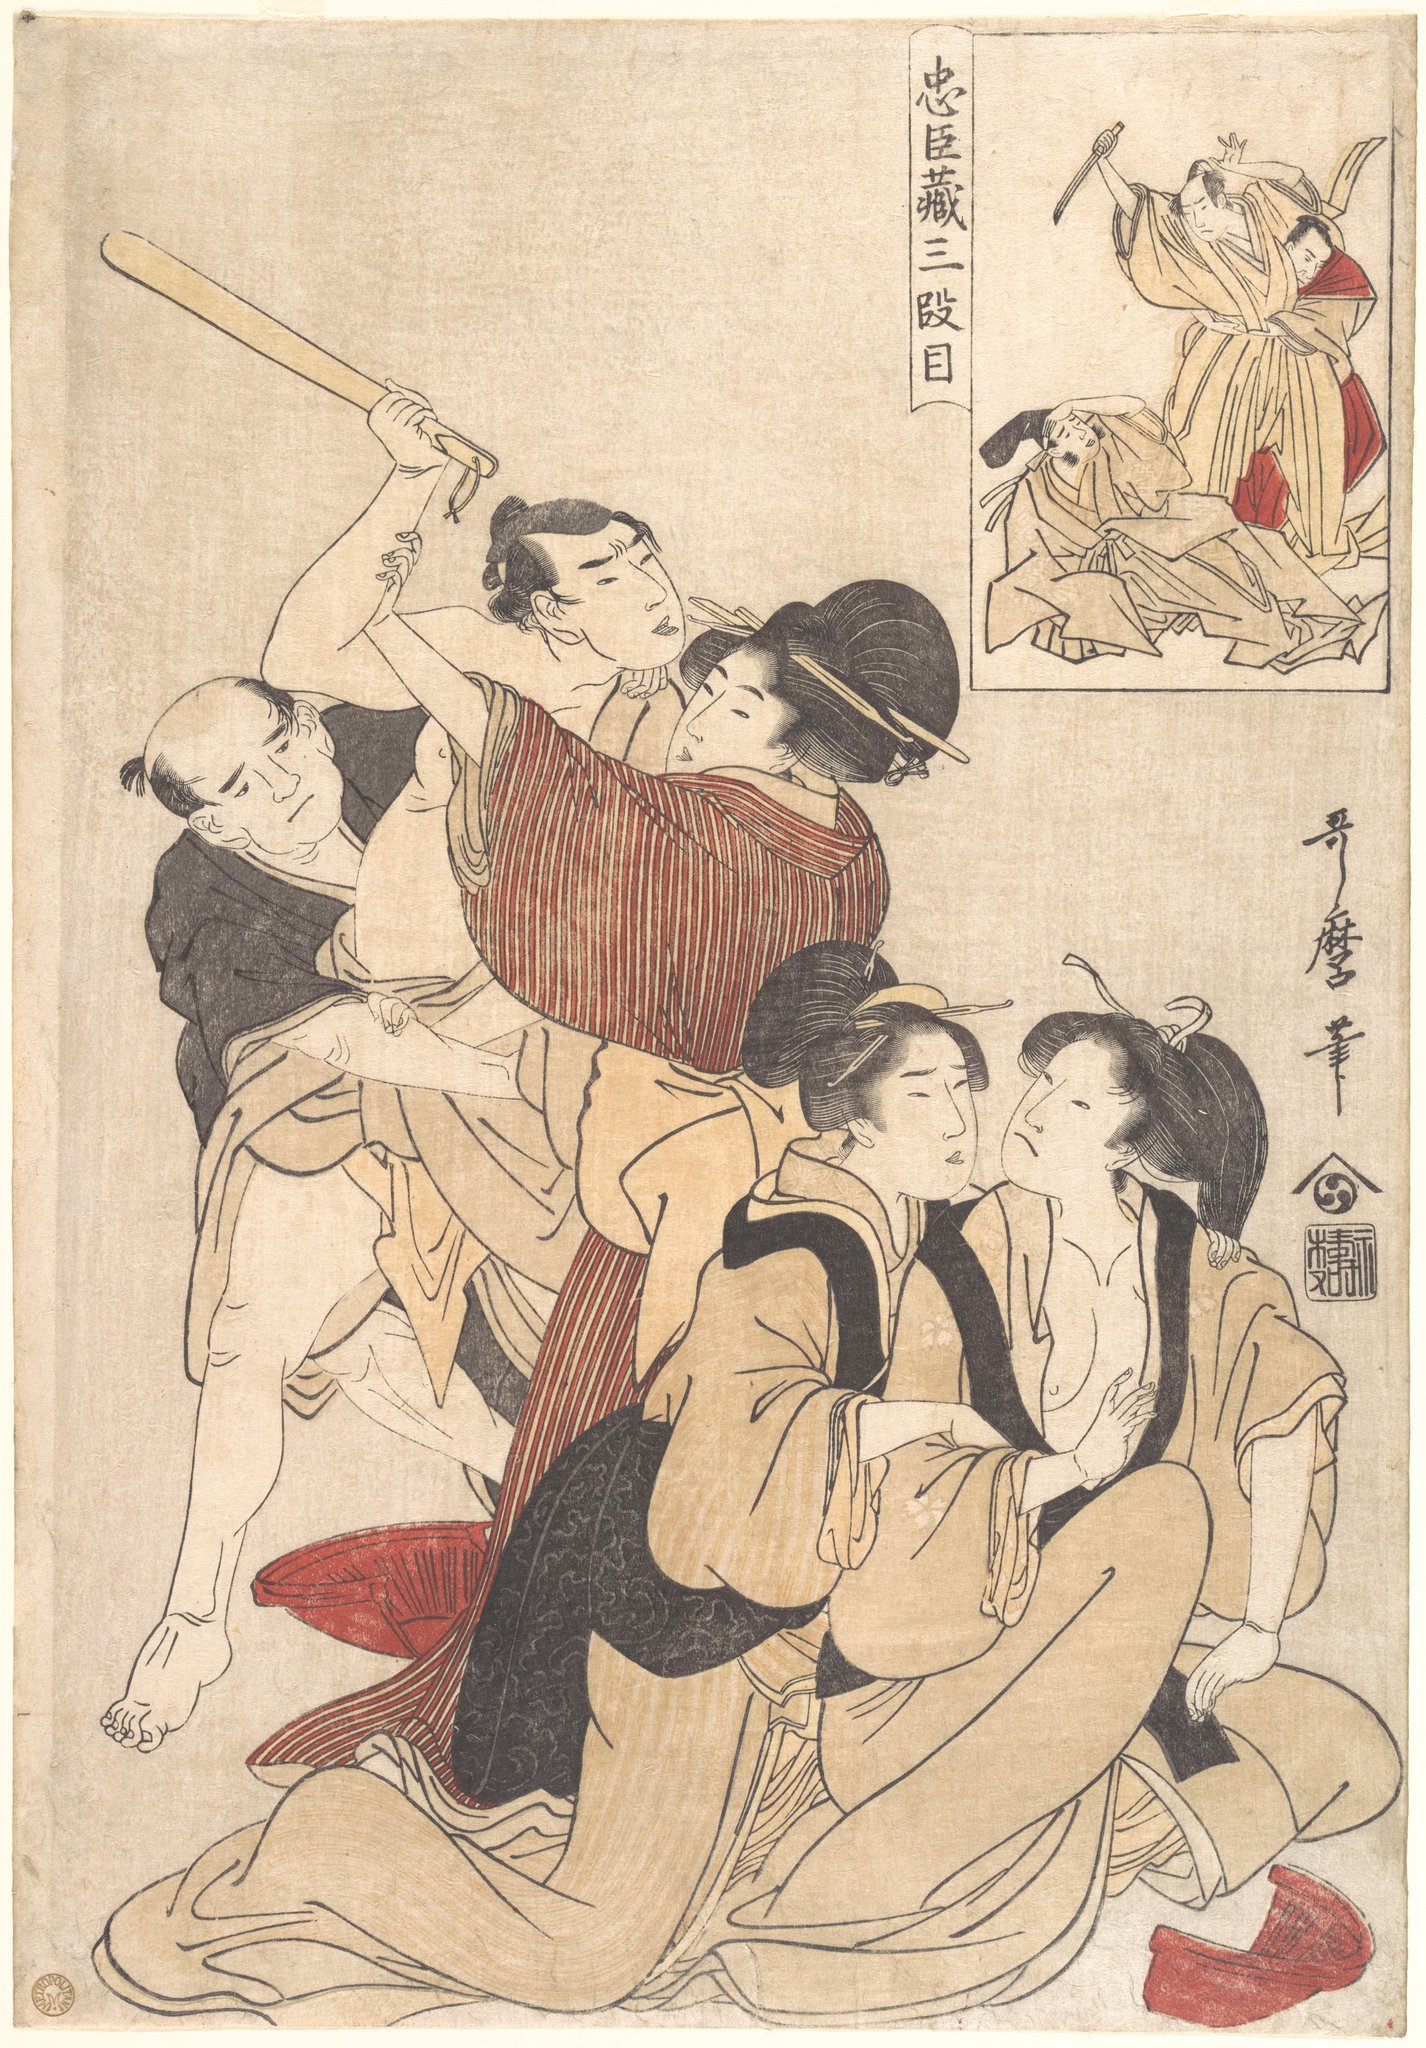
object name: print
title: Chushingura Act III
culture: japanese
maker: kitagawa utamaro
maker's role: artist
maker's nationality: japanese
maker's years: 1754-1806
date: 1800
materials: ink, paper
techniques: woodblock print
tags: theatre,men,women